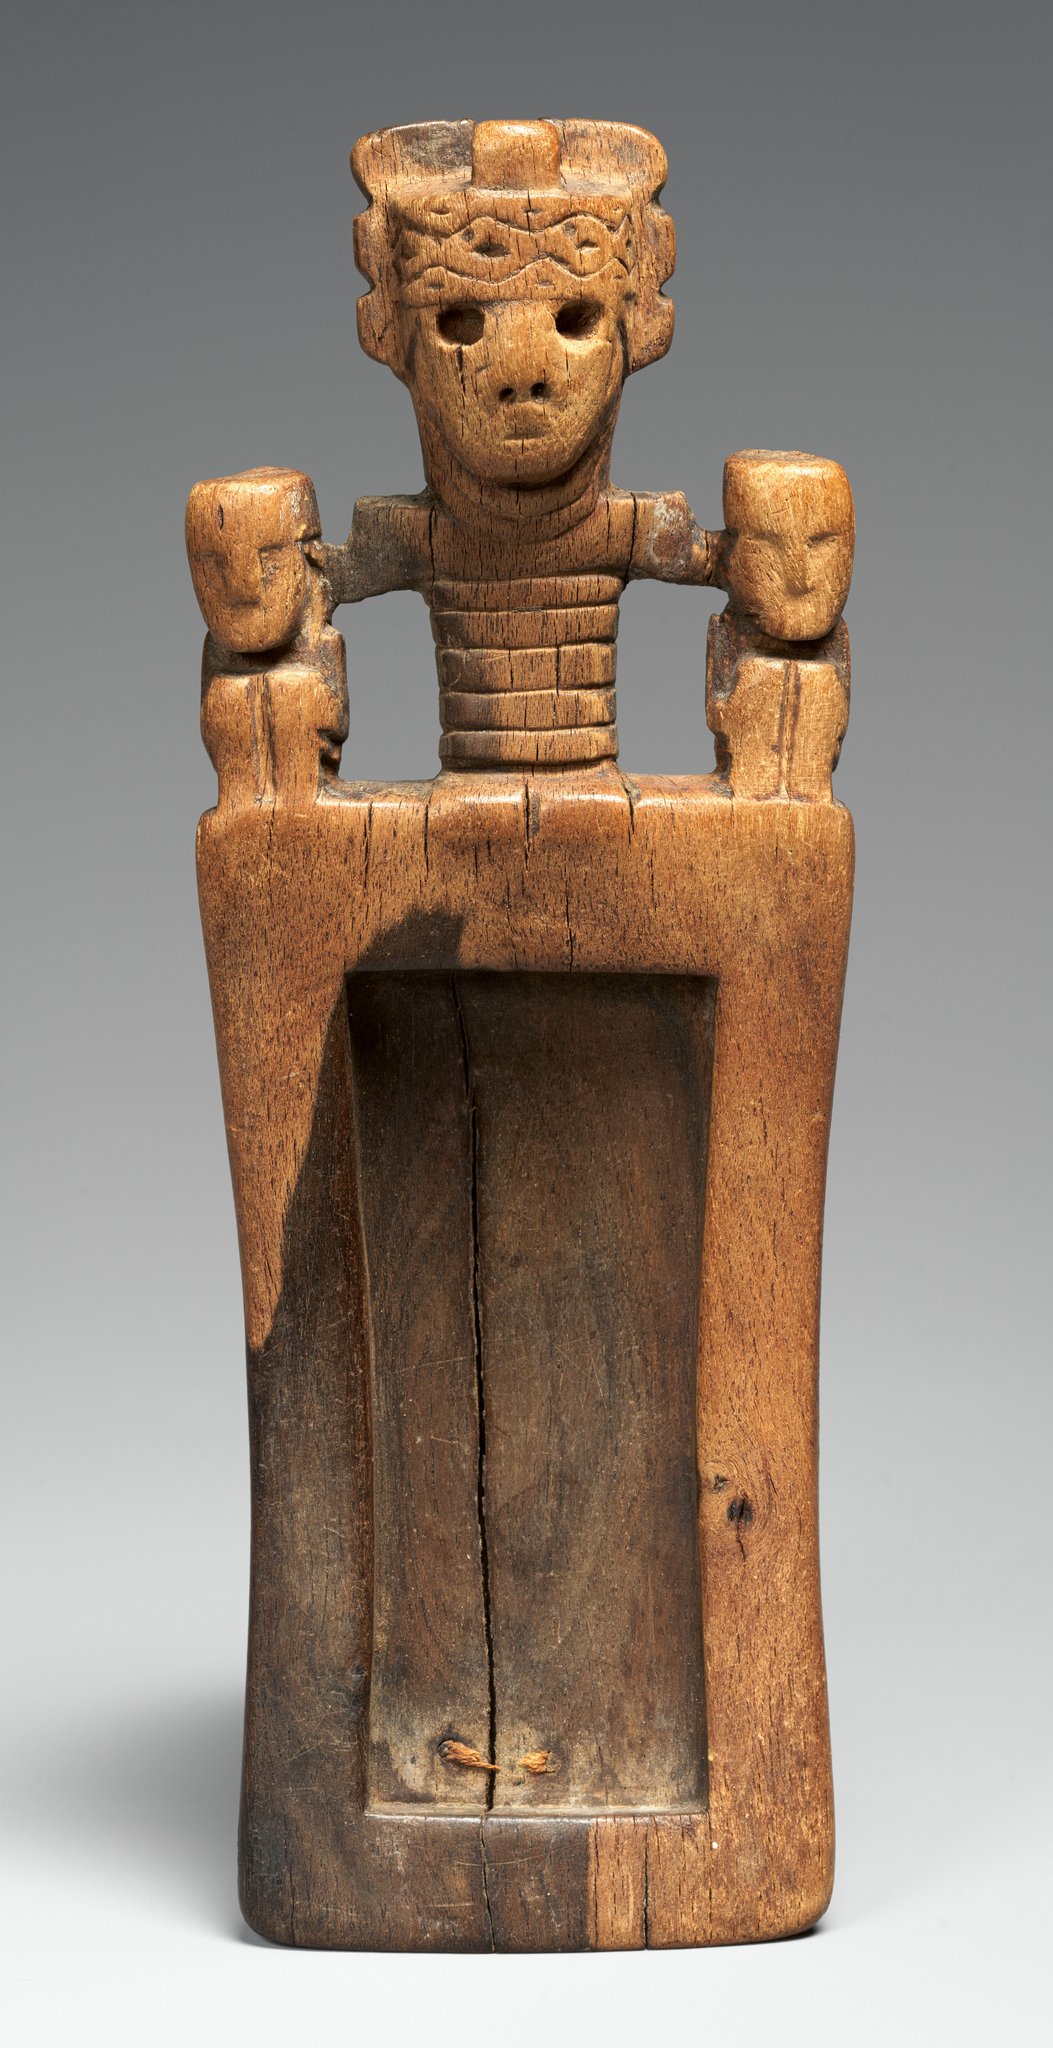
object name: snuff tray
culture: tiwanaku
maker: tiwanaku artist(s)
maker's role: artist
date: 500-1000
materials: copper alloy, fiber, wood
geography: argentina, bolivia, or chile